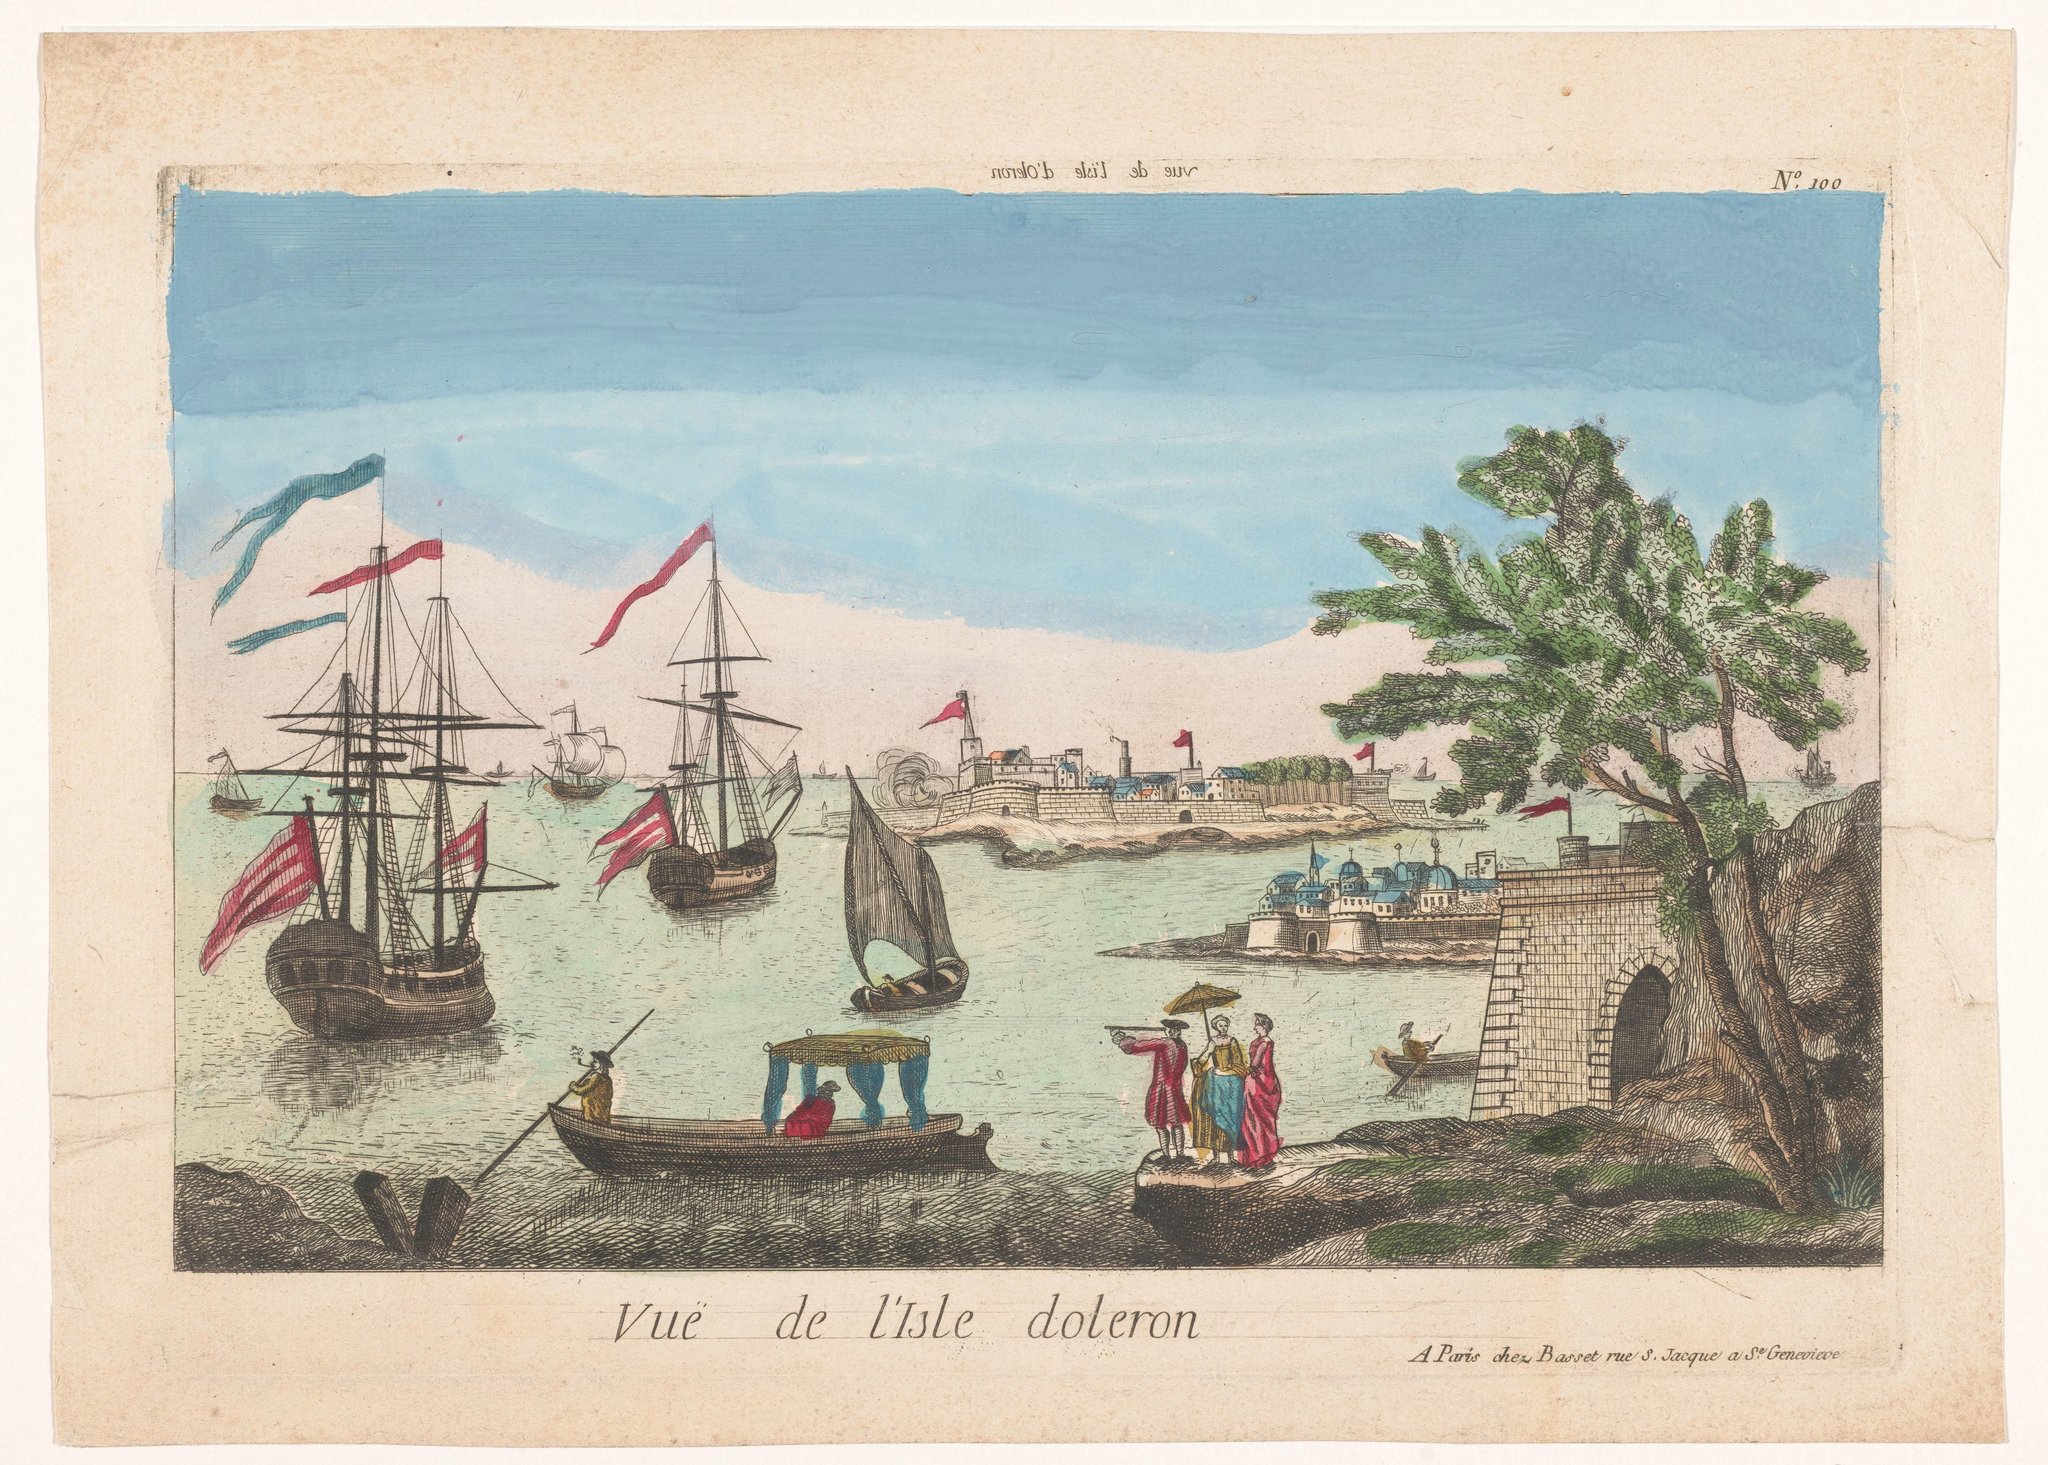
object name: opticaprent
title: Gezicht op het eiland Oléron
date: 1700-1799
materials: paper, watercolor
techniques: brush, etching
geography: france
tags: sailing-ship, sailing-boat, island (+ landscape with figures, staffage), rowing-boat, canoe, etc., france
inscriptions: collector's mark: Lugt 2233, watermark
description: Op het water liggen schepen en boten. Op de voorgrond staan twee vrouwen met een parasol en een man met een monokijker aan de waterkant. Genummerd: 100.